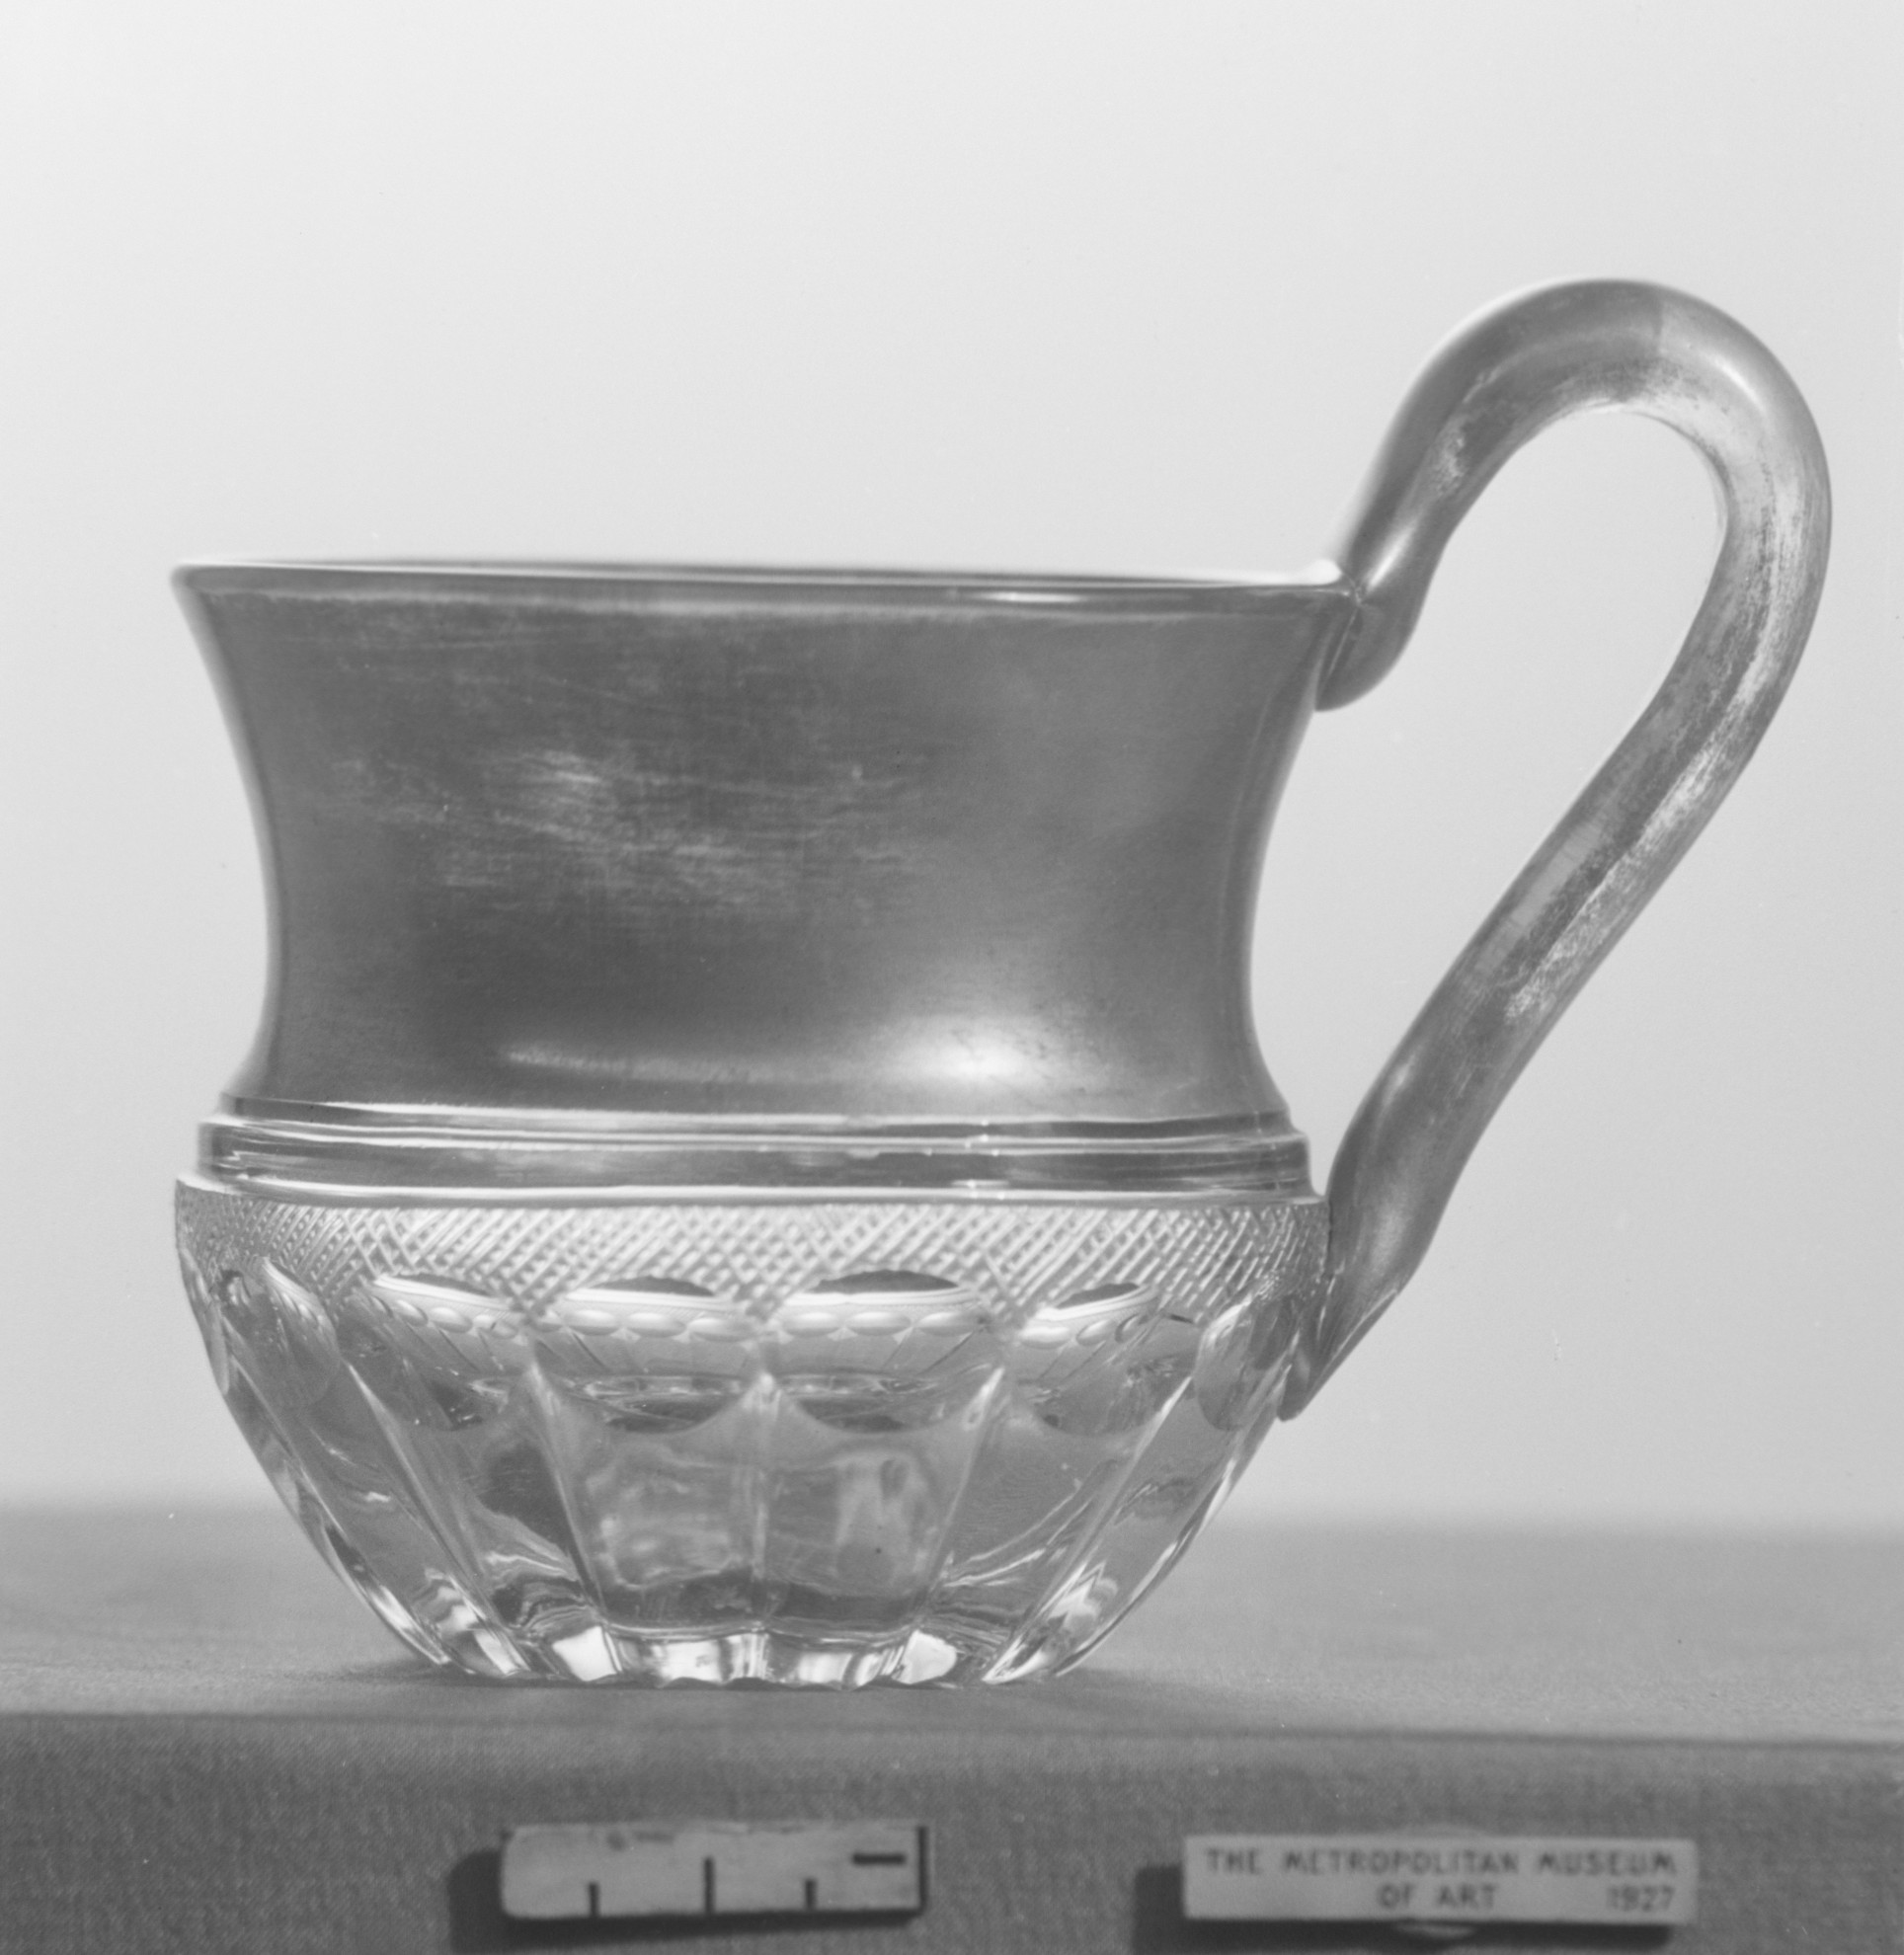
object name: cup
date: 1815-1820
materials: glass